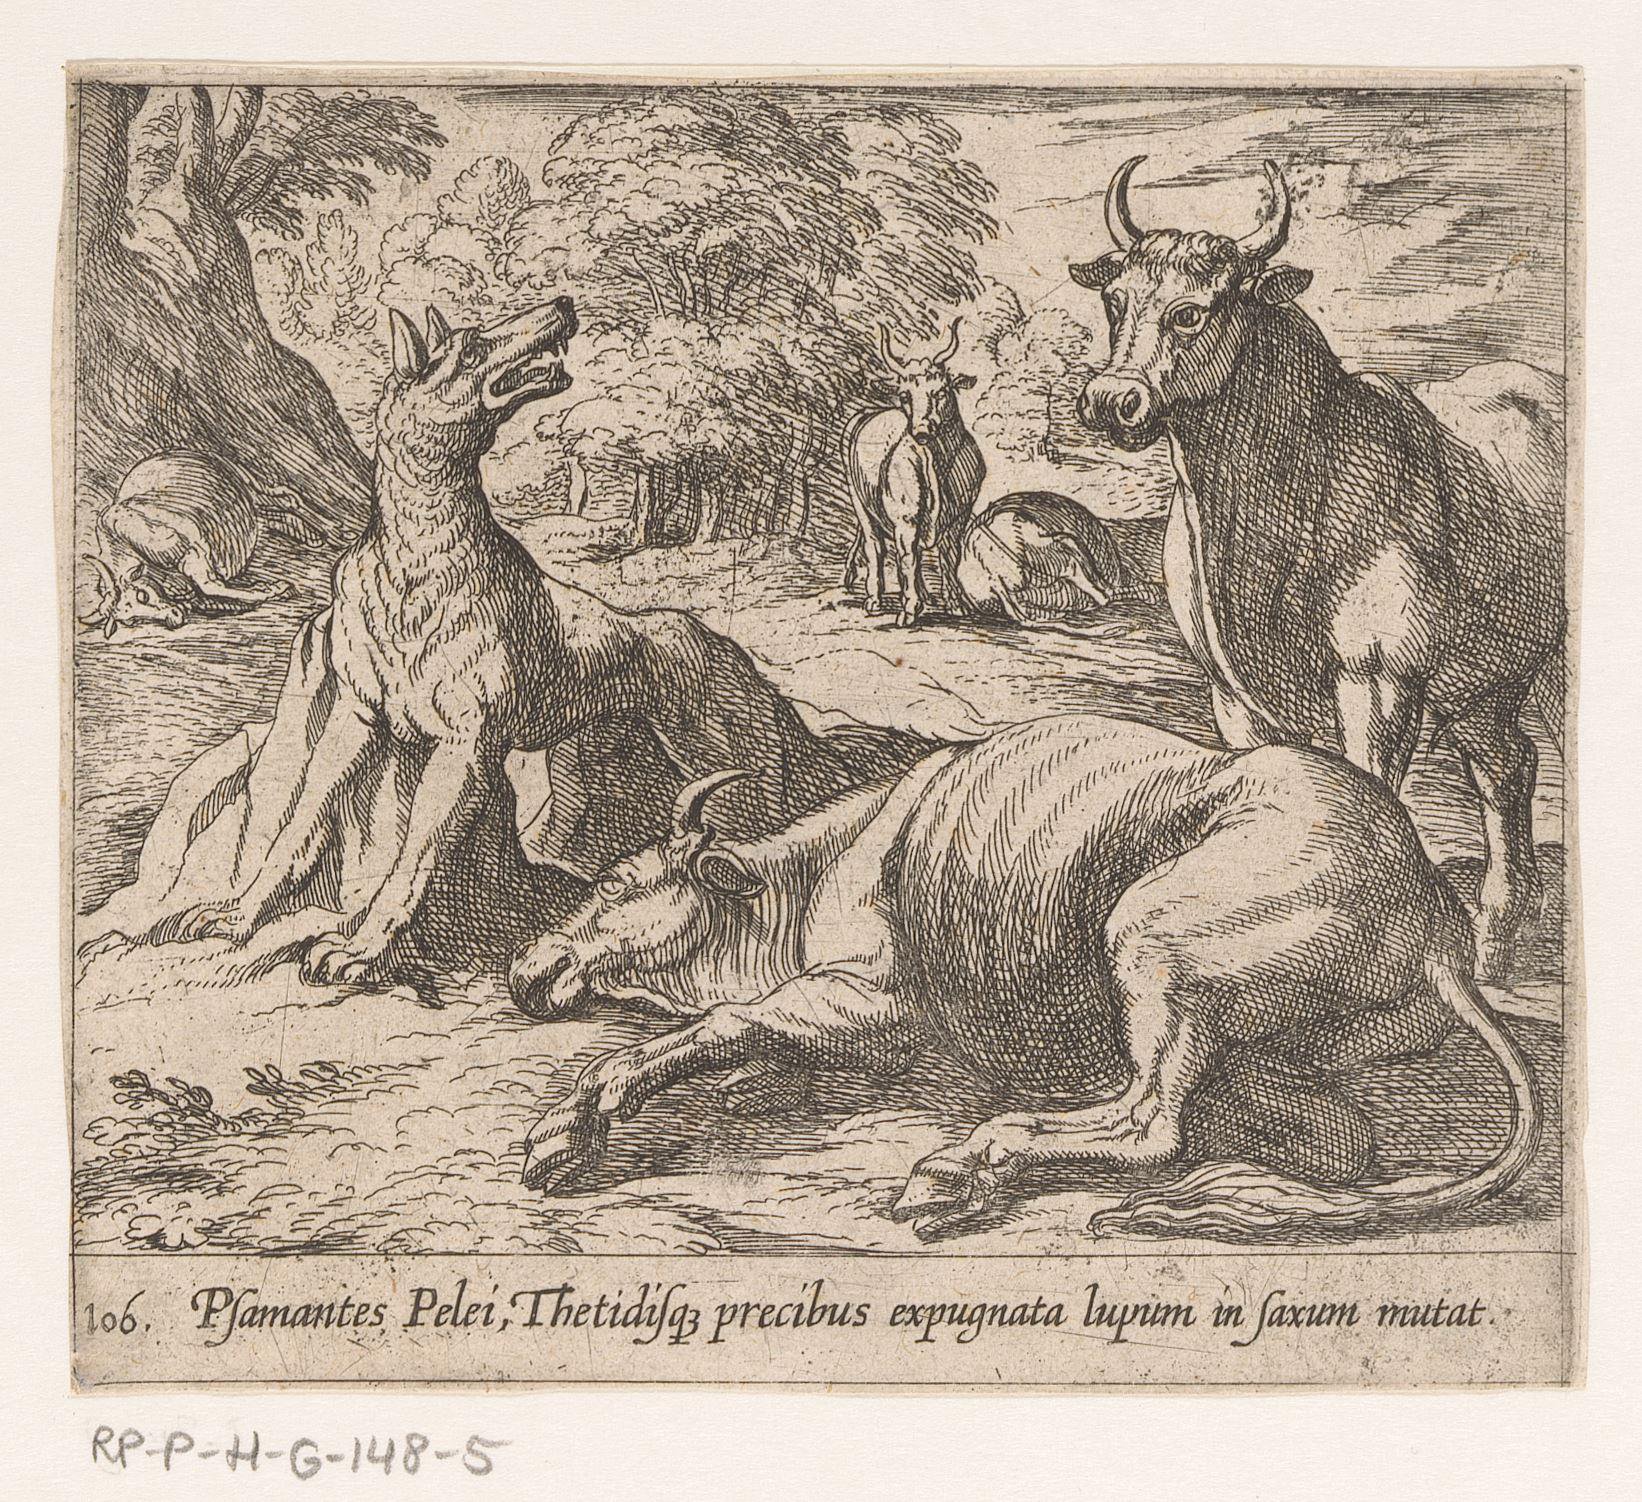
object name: print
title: Metamorphoseon sive transformationum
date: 1606-1638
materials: paper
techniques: etching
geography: amsterdam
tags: wolf turned to marble: at the prayer of peleus and thetis, a wolf is turned into marble by psamathe because it had attacked the cattle that peleus was herding on the sea-shore (ovid, metamorphoses x 401)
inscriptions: collector's mark: ‘Hinloopen’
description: Door het gebed van Peleus en Thetis wordt de wolf die de kudde van Peleus aanvalt in marmer veranderd. Titel in het Latijn in ondermarge.